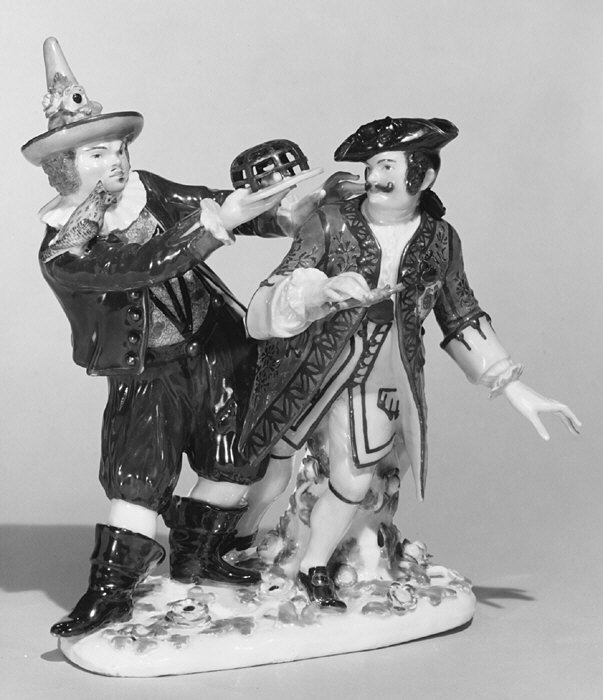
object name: group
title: Froehlich and Schmiedel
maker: meissen manufactory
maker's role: manufactory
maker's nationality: german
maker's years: 1710-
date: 1741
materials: hard paste porcelain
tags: birds,men